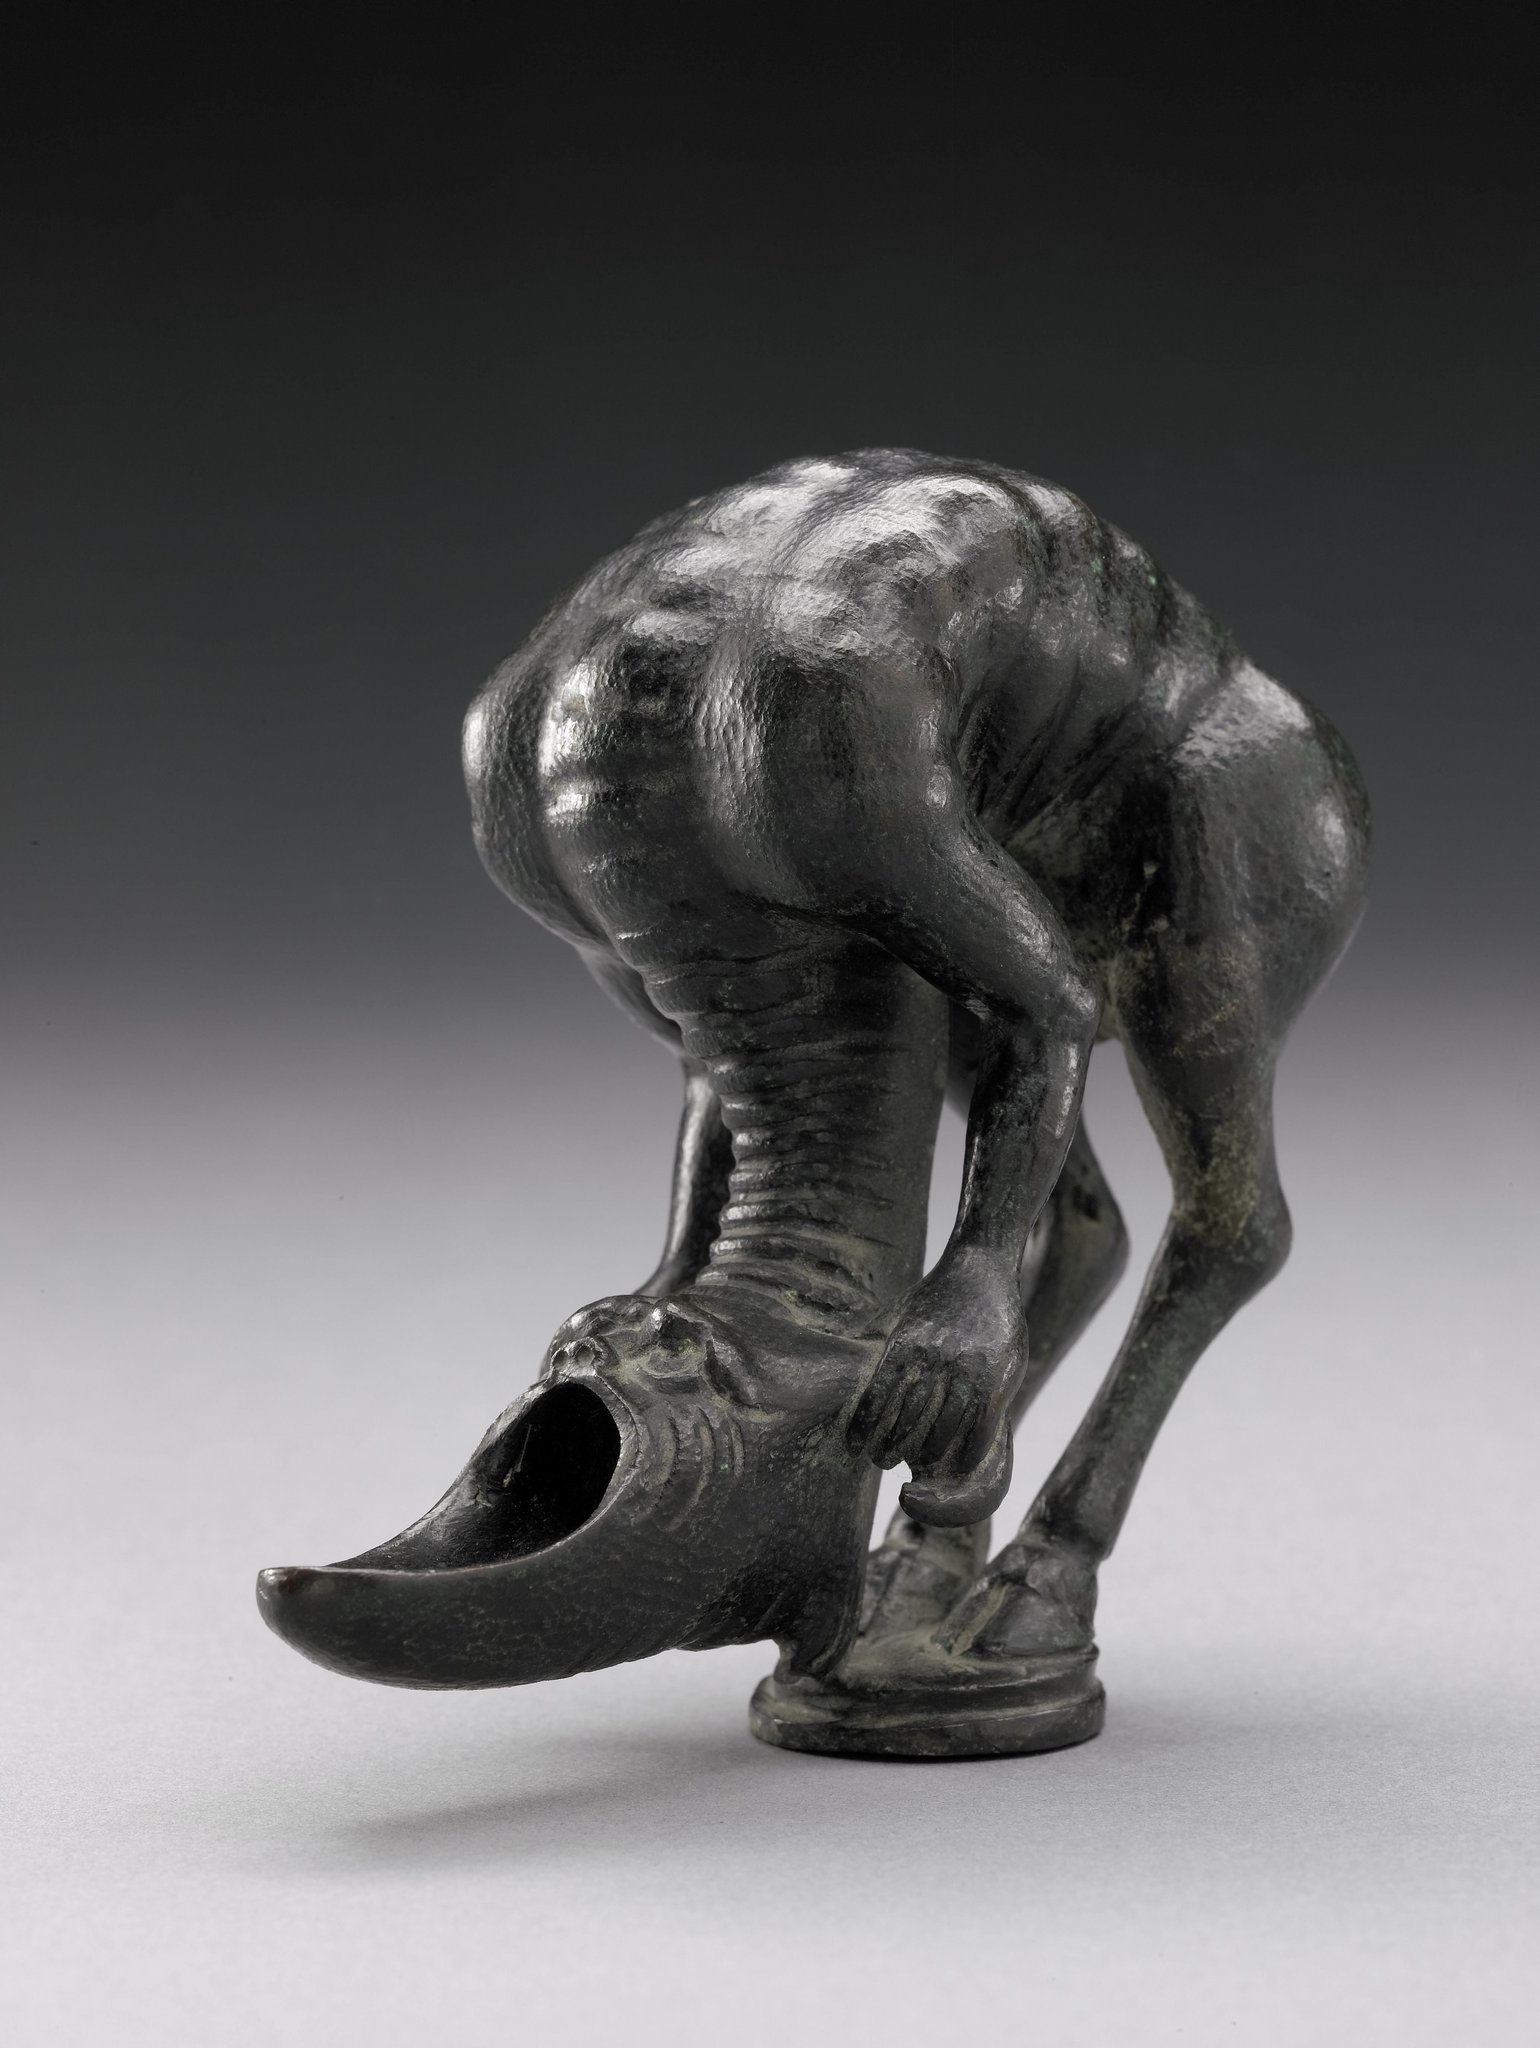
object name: figure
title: Grotesque Animal, Oil Lamp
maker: arent van bolten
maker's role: draughtsman, print maker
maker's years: 1573-1633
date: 1610-1650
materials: bronze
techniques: lacquer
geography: low countries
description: Attributed to Arent van Bolten (1573-1624/26). Grotesque animal. Bronze. Zwolle(?), c. 1610-1630.